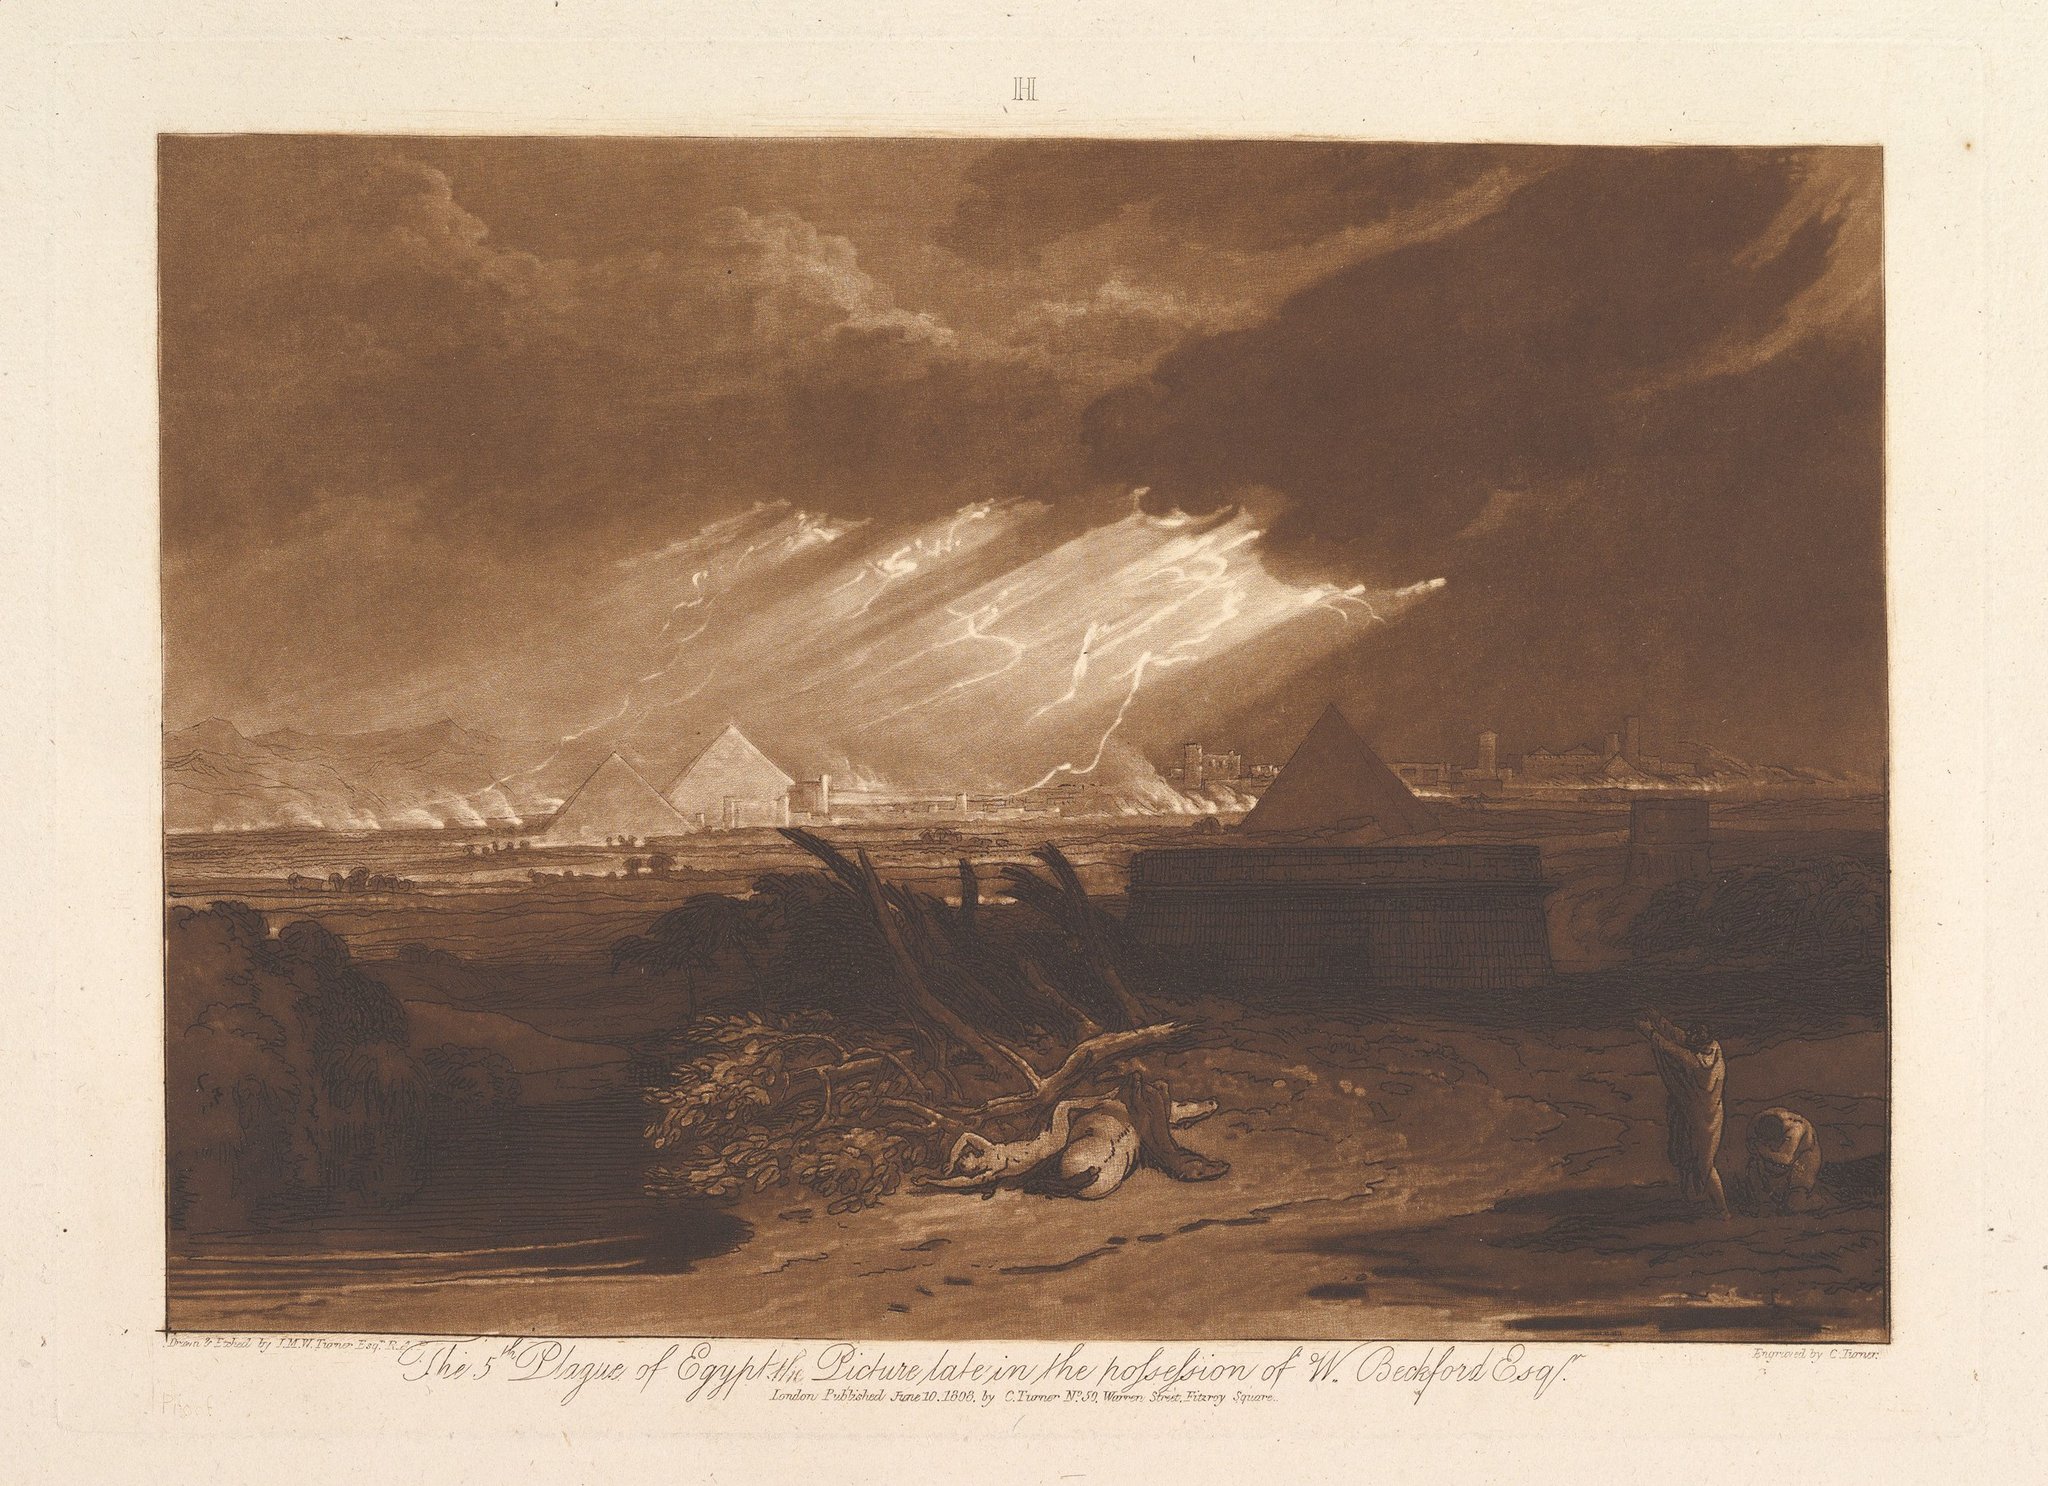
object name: print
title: The Fifth Plague of Egypt, part III, plate 16 from "Liber Studiorum"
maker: joseph mallord william turner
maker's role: artist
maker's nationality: british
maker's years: 1775-1851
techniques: etching, mezzotint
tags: landscapes